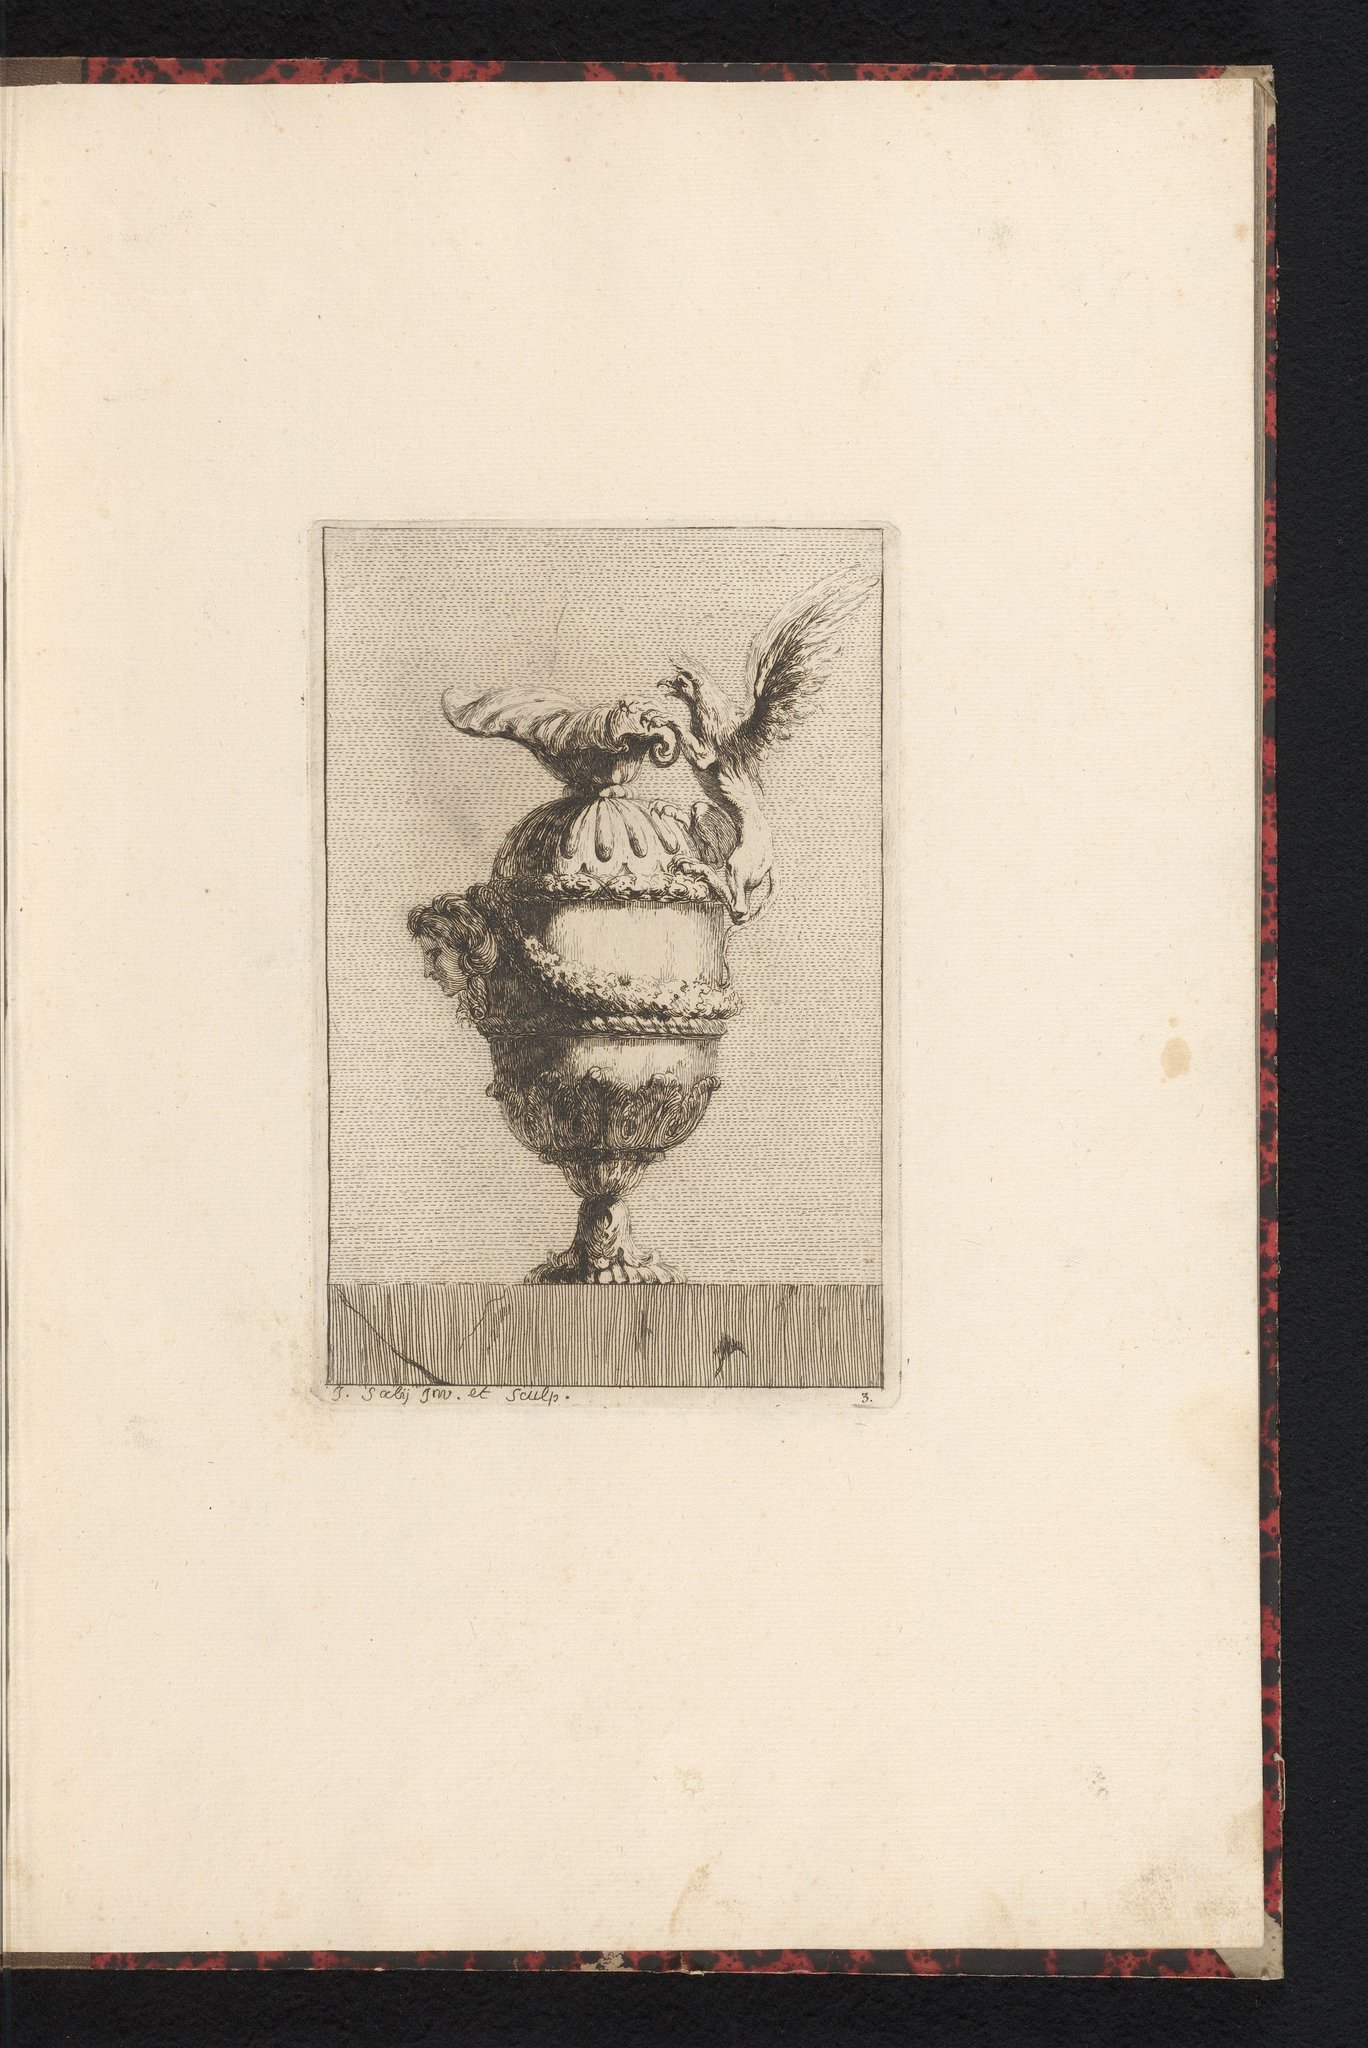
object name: album leaf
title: Ontwerpen voor vazen door Jacques Saly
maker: jacques francois joseph saly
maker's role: print maker, sculptor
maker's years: 1717-1776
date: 1746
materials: paper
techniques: etching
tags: griffin (lion/eagle); 'griffo' (ripa), garden vase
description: Deze prent maakt deel uit van een album.